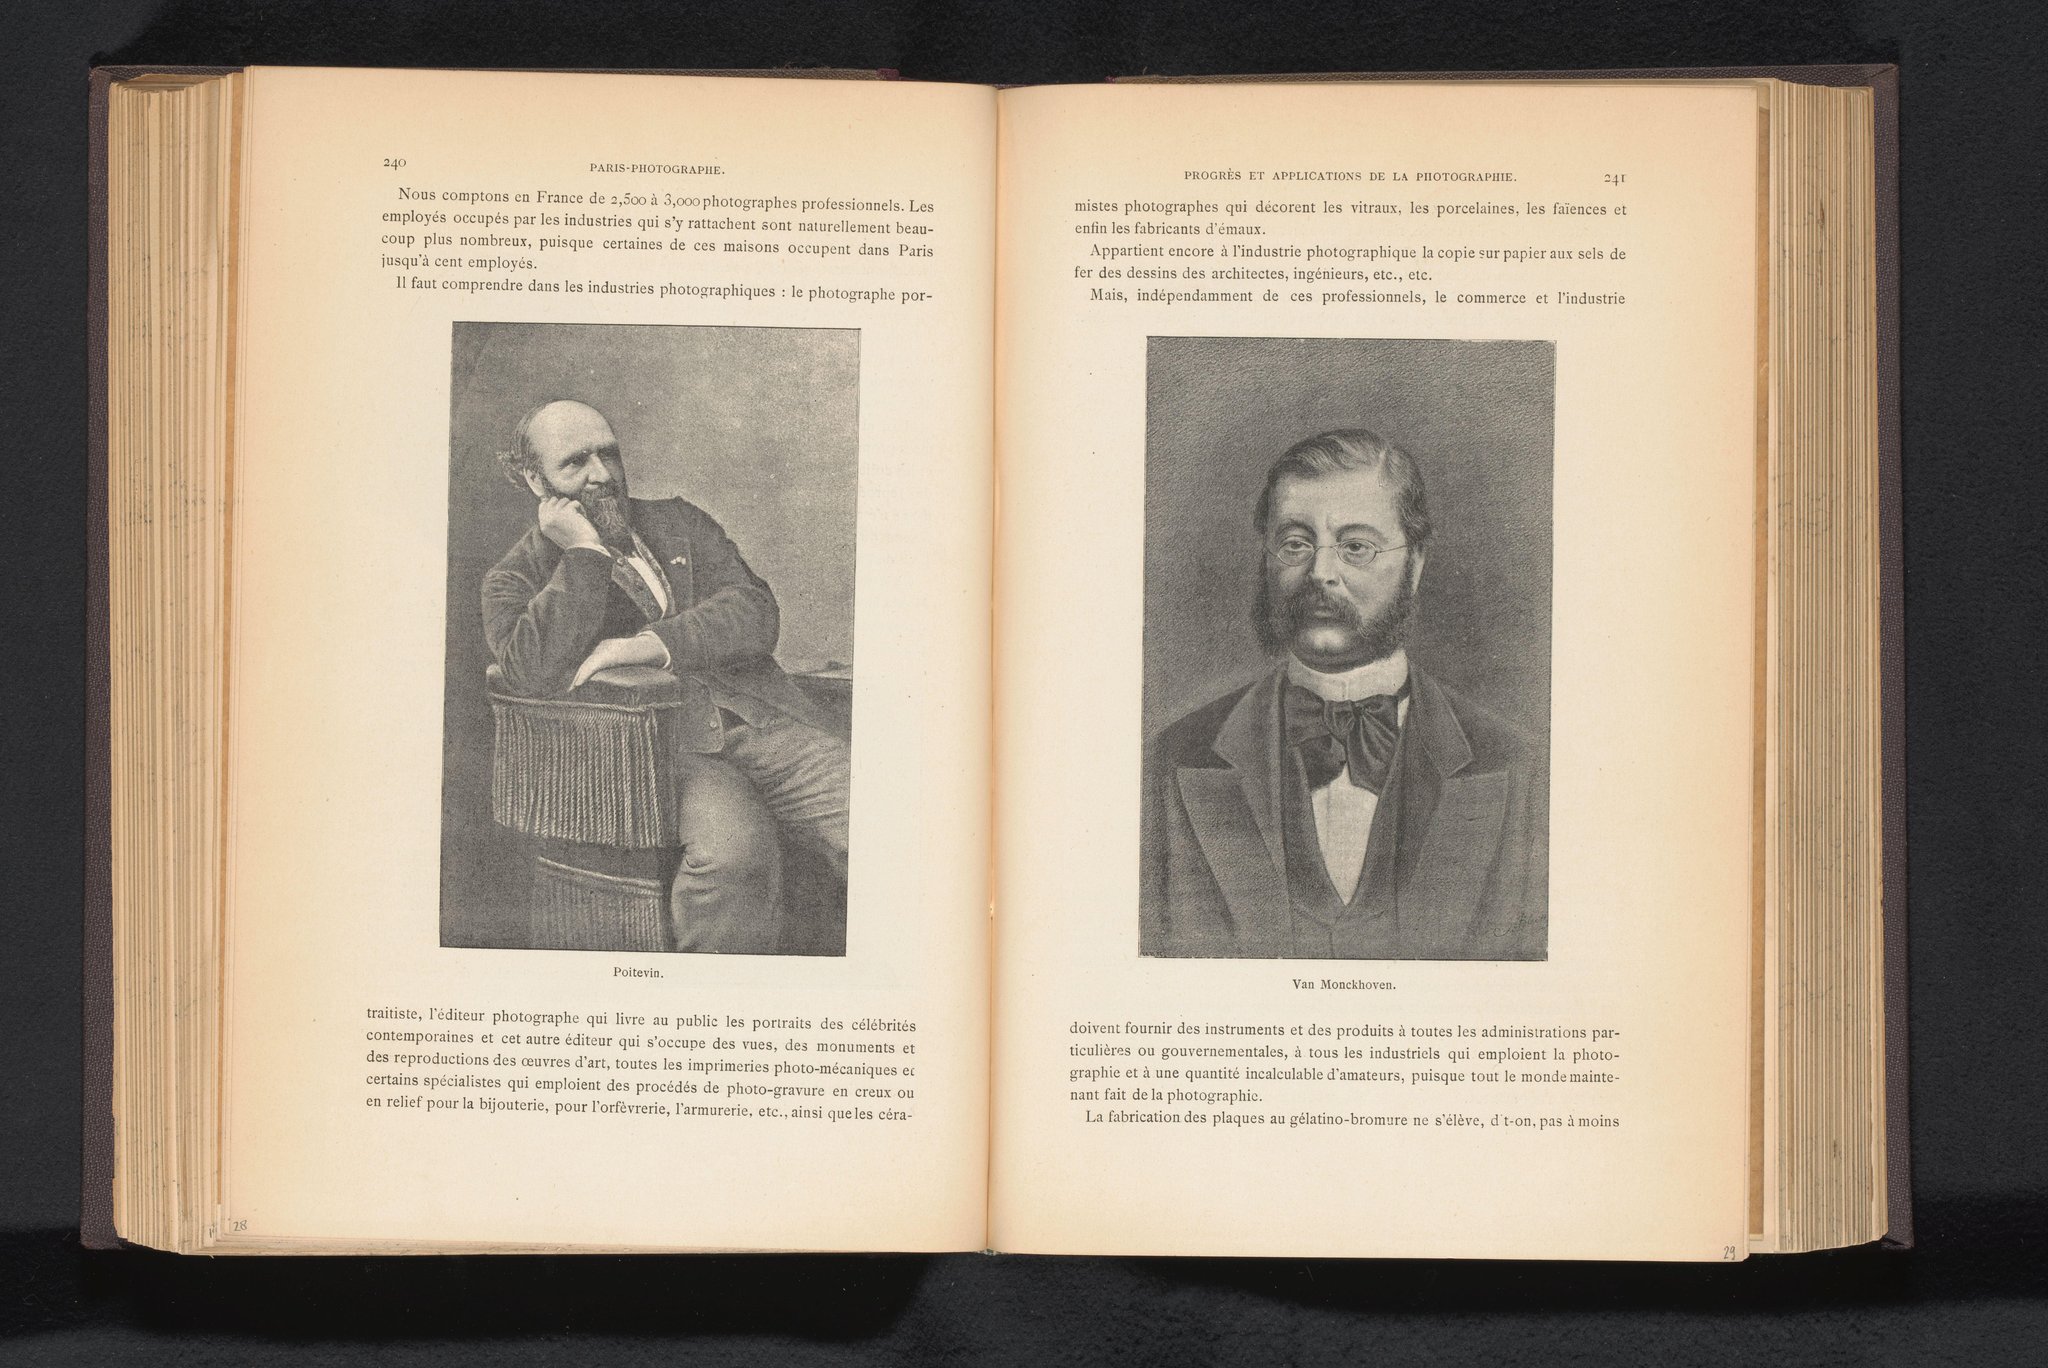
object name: reproduction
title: Van Monckhoven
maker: Anonymous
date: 1882-1892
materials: paper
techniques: autotype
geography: france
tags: ghent, désiré van monckhoven, portrait of a writer